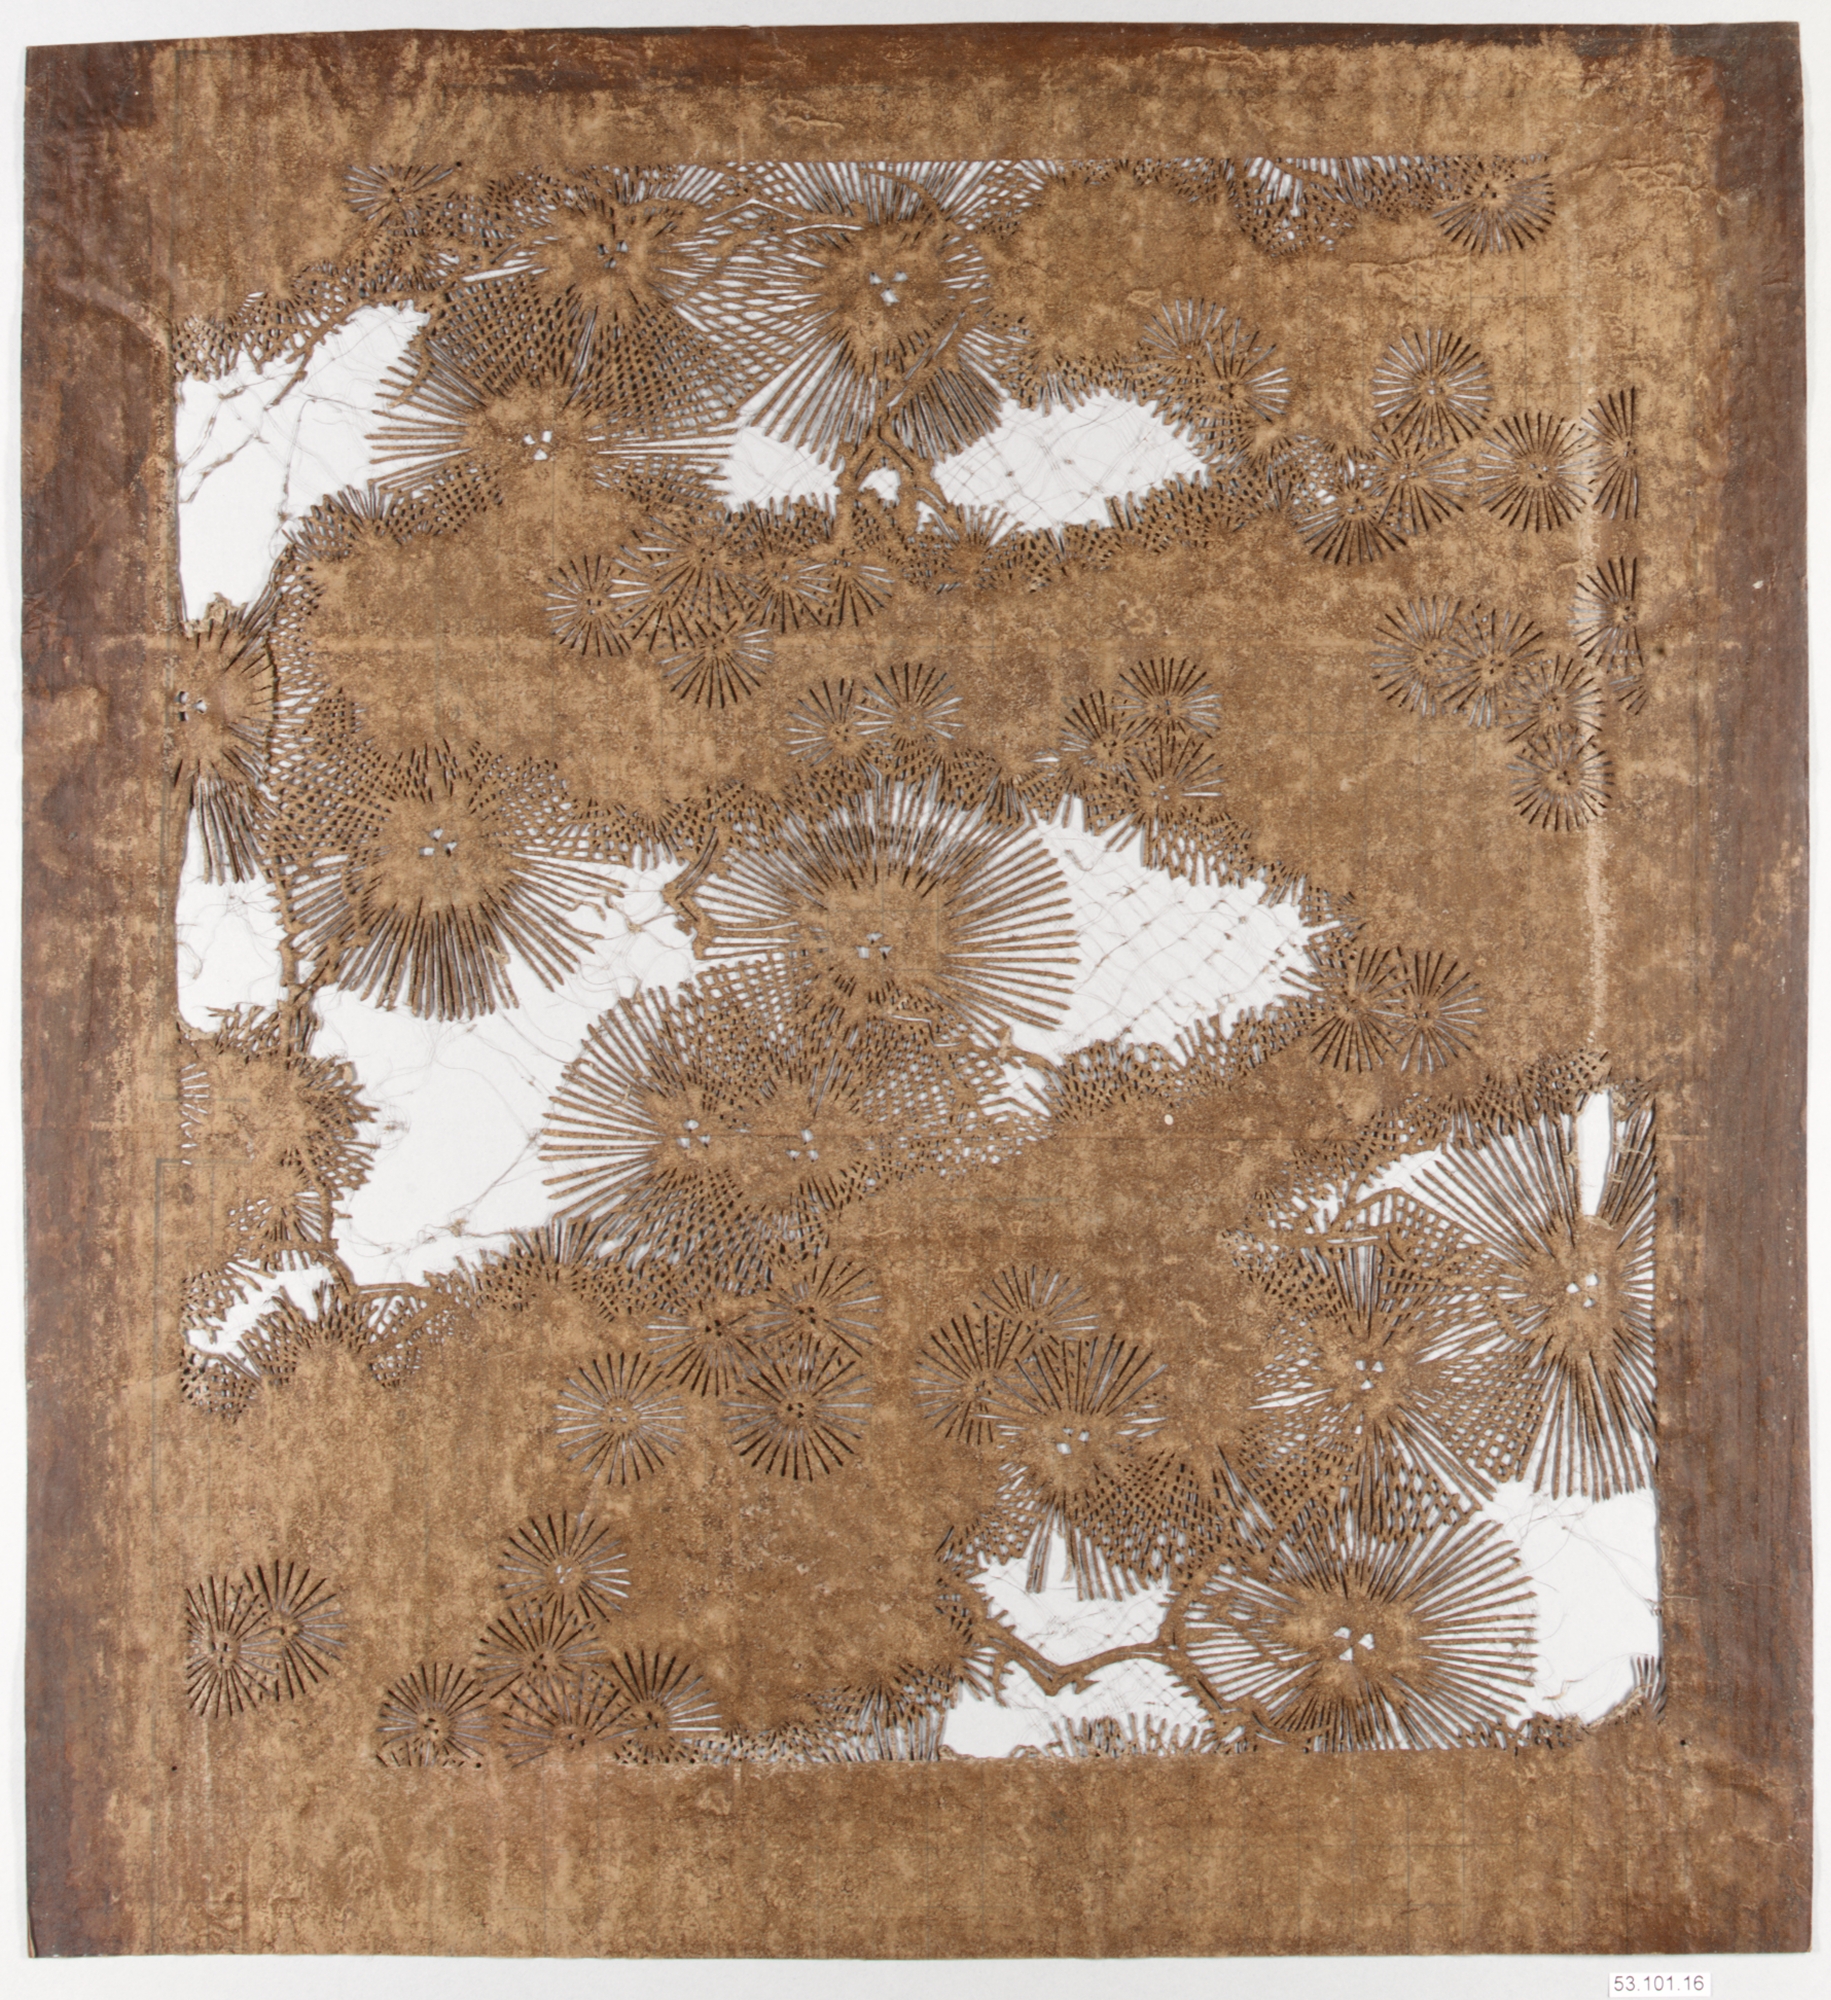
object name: stencil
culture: japanese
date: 1615-1868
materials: paper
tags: flowers